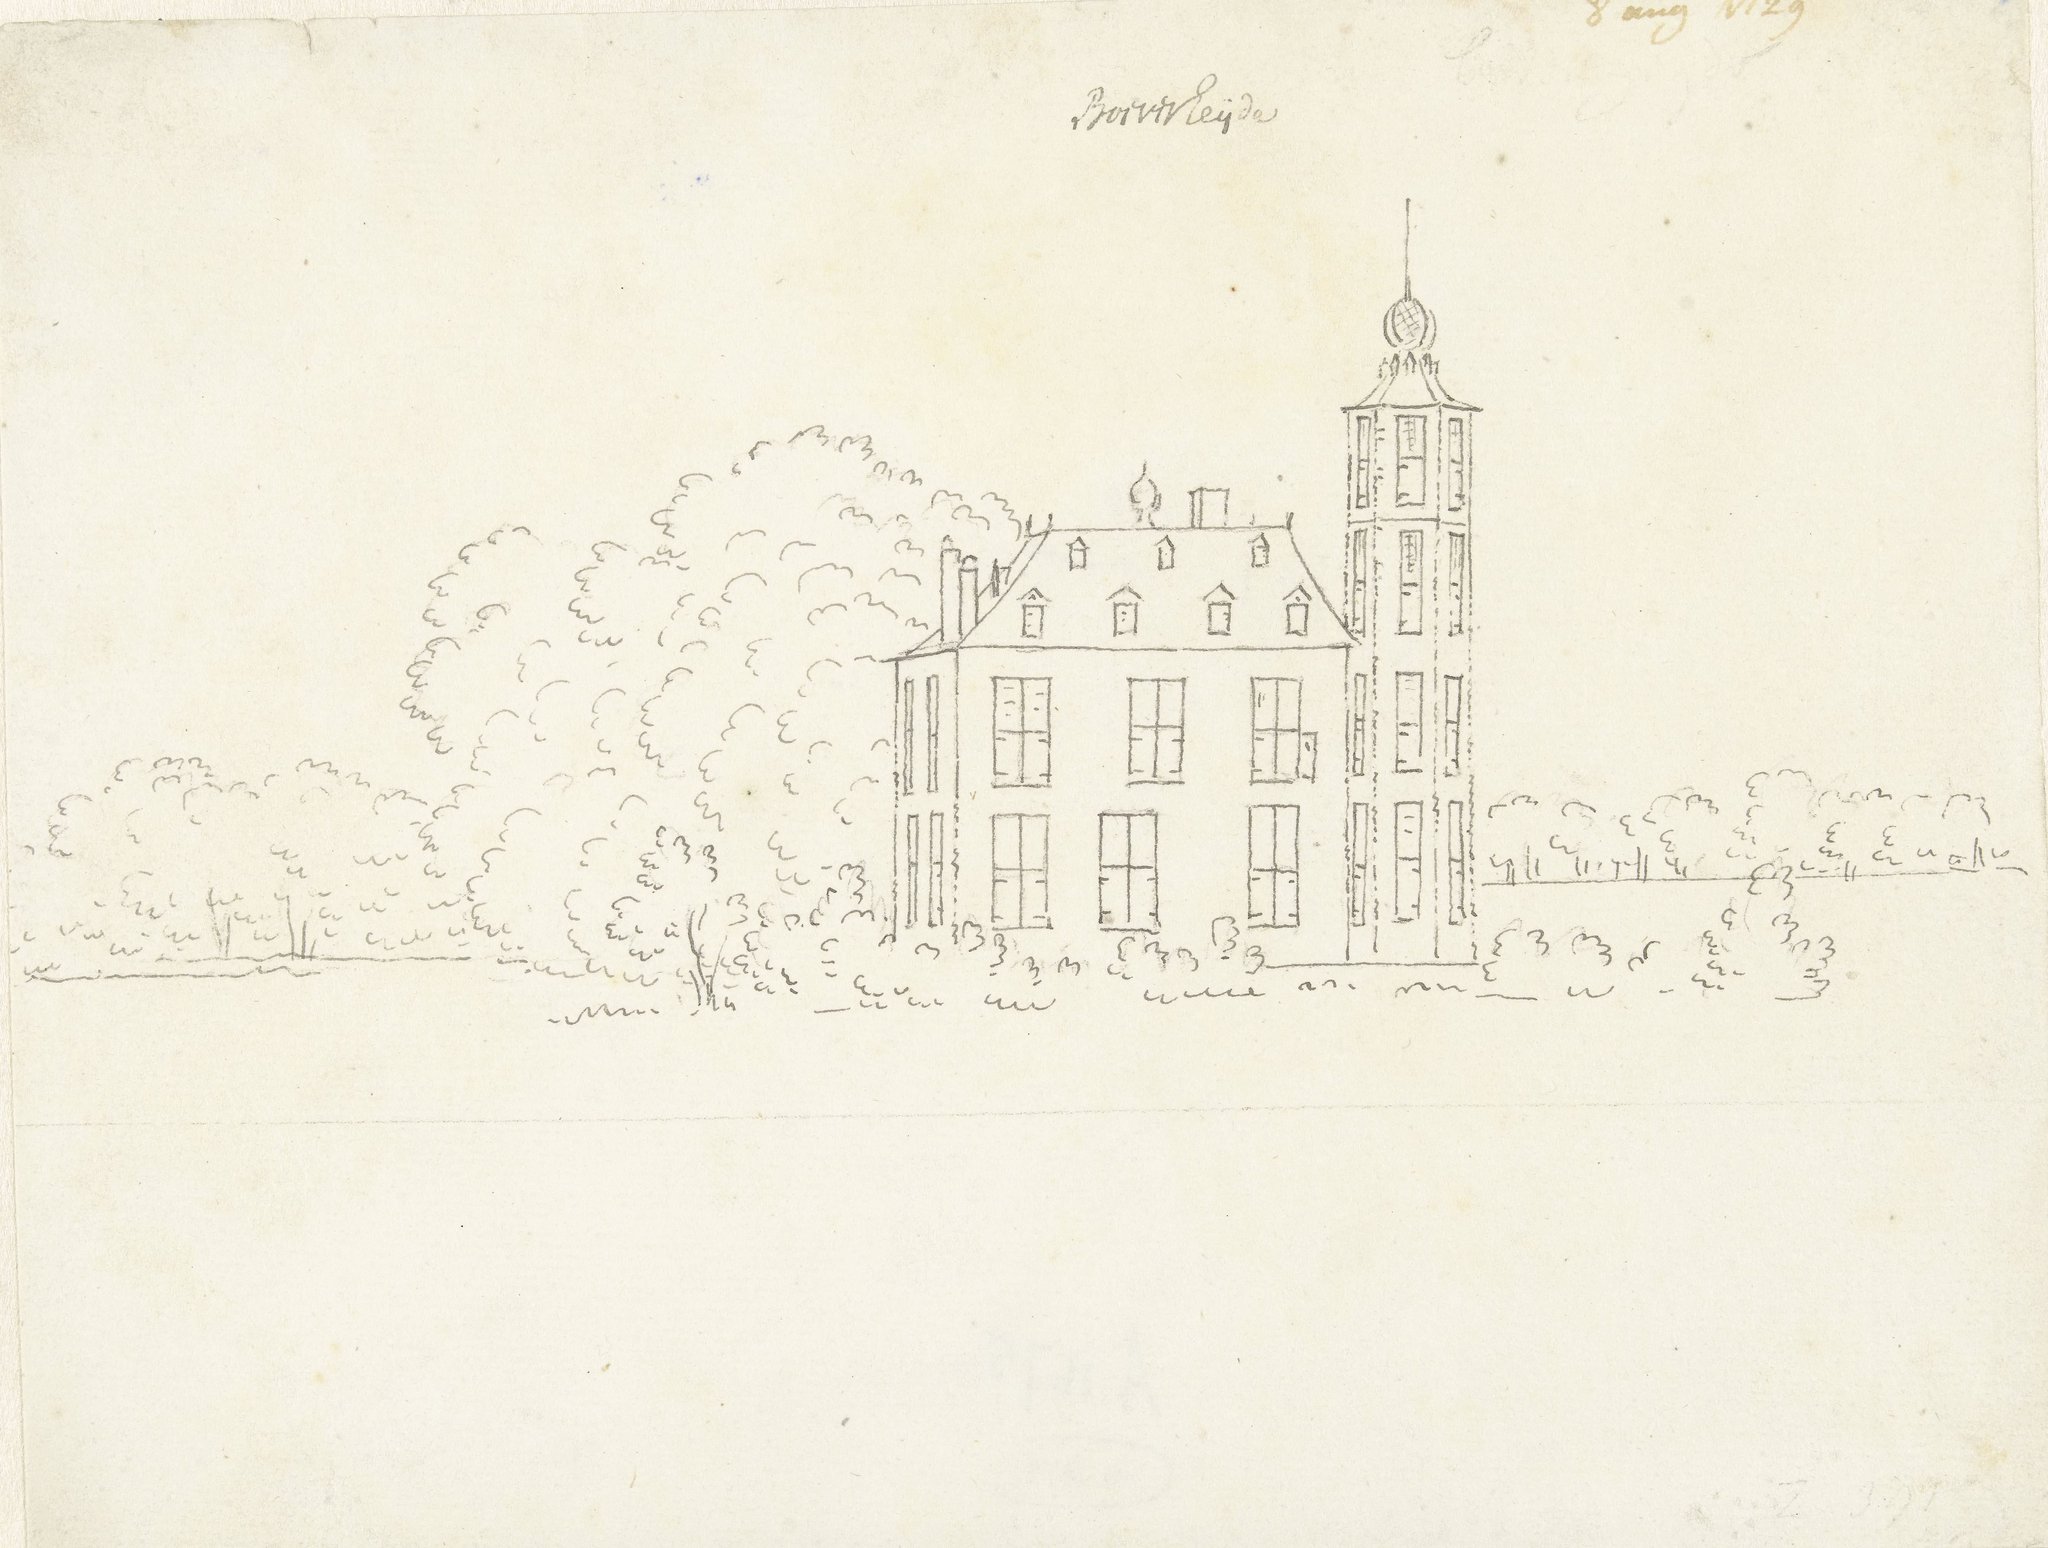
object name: drawing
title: Kasteel Bouvigne bij Breda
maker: cornelis pronk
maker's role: draughtsman, painter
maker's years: 1691-1759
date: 1729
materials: ink, paper, pencil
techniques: pen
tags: castle, rural housing, e.g. country-house, villa, cottage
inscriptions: inscription: ‘Boeveleijde / 8 aug 1729’